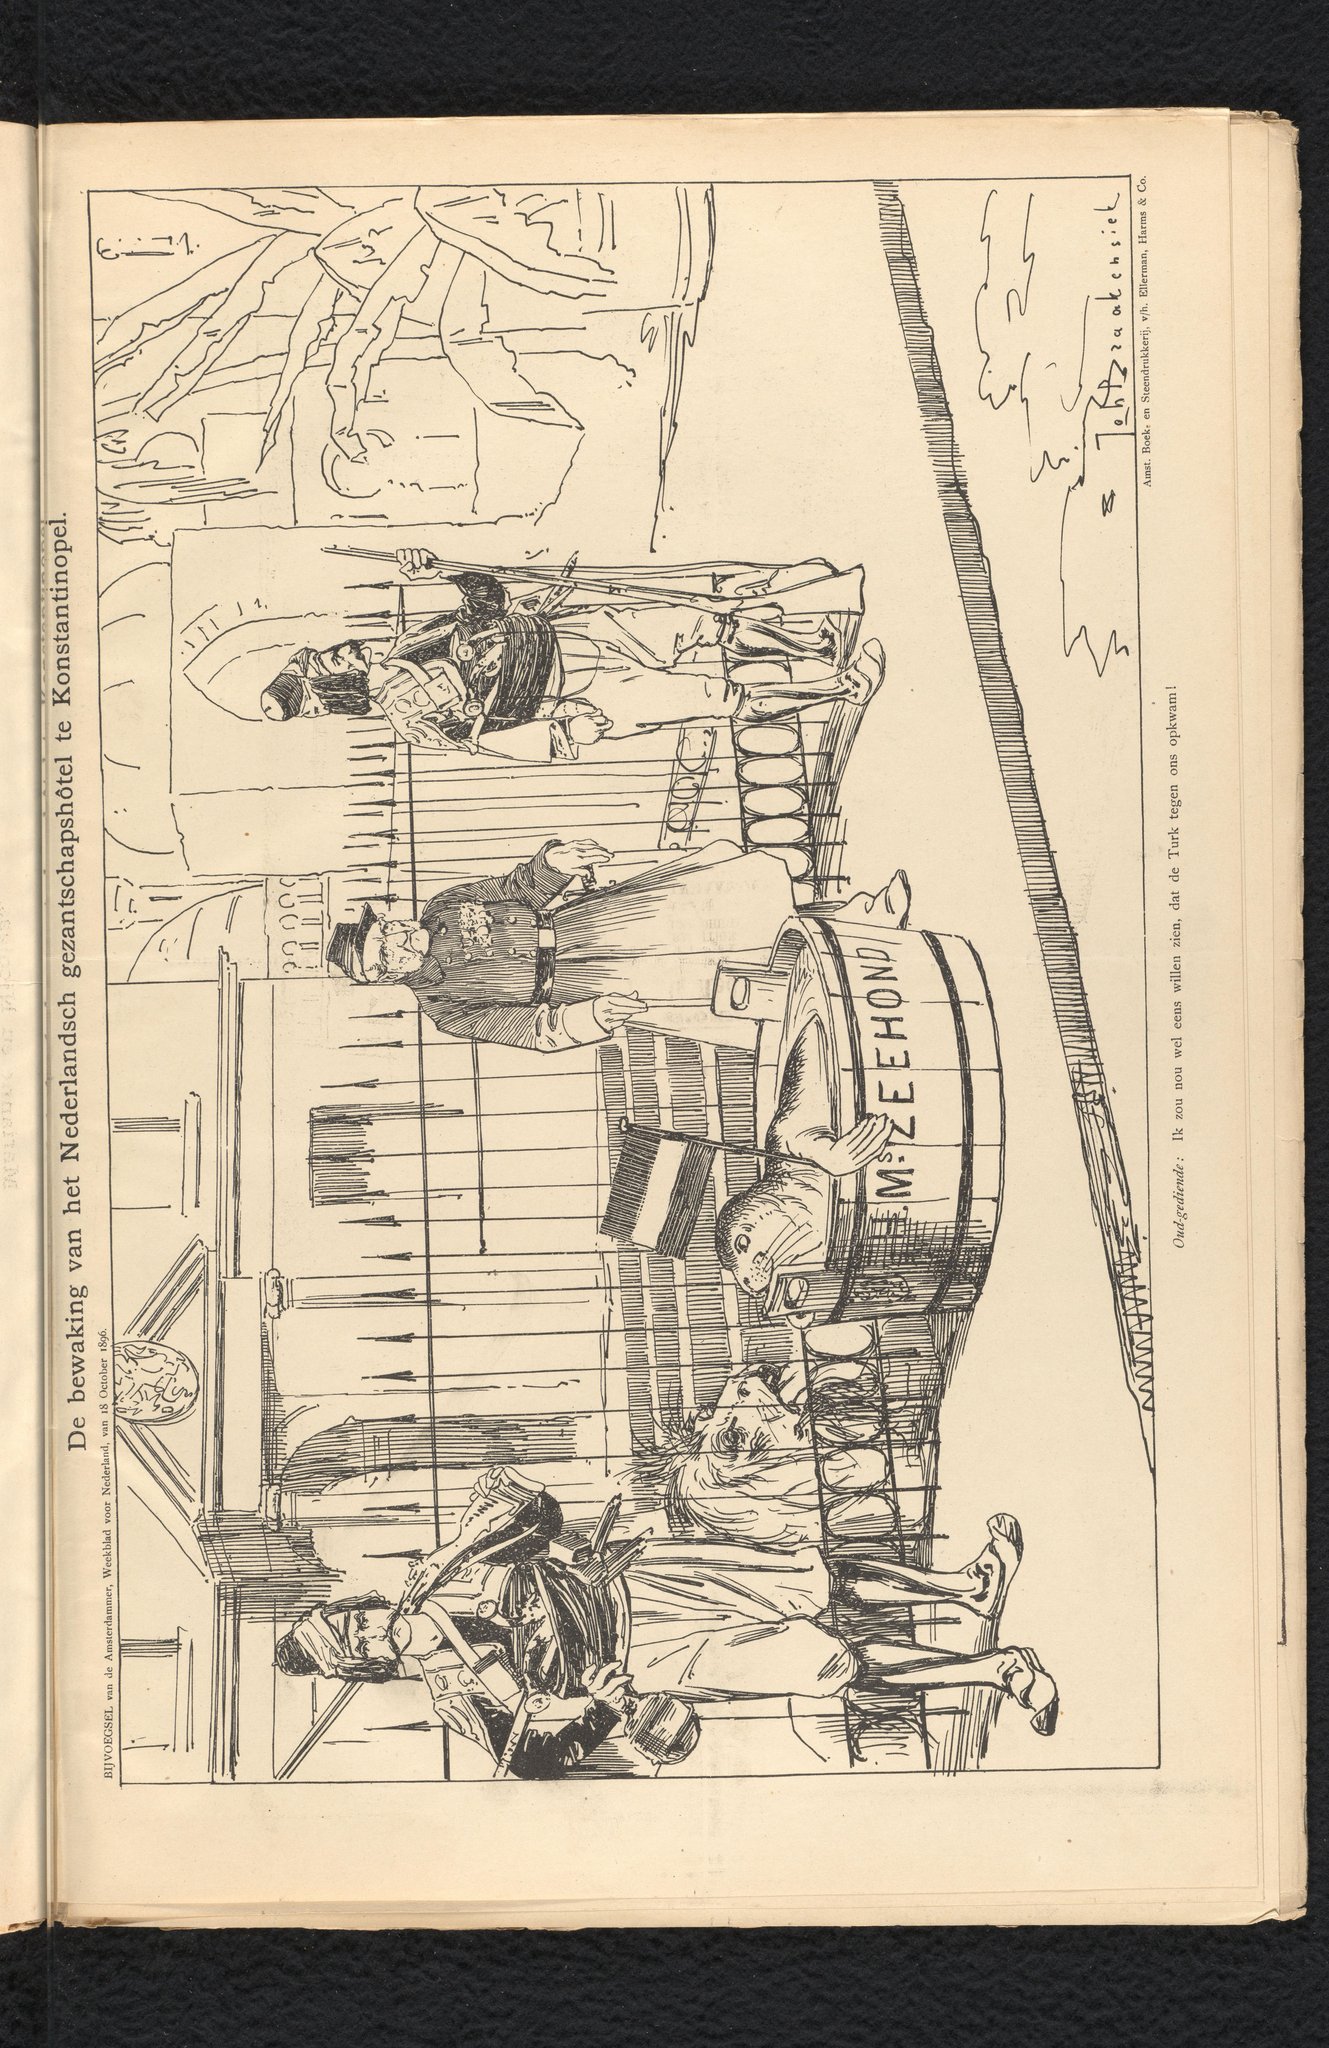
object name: cartoon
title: De bewaking van het Nederlandsch gezantschapshôtel te Konstantinopel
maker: johan braakensiek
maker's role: draughtsman, print maker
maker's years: 1858-1940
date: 1896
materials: paper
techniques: lithograph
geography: amsterdam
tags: personifications of countries, nations, states, districts, etc., veteran, diplomacy, diplomat, navy, swimming mammals: seal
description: De Nederlandse ambassade in Constantinopel bewaakt door twee lokale soldaten, een gepensioneerde Nederlandse veteraan en een zeehond (H. Ms. Zeehond) in een houten tobbe. [Marinemuseum Den Helder: De prent verwijst naar Hr.Ms. schoener Zeehond die in 1896 en 1897 in Turkse wateren verbleef in verband met een uitgebroken oorlog tussen Griekenland en Turkije. De 'Zeehond' was gestuurd met het doel de Nederlandse belangen in die regio te beschermen.]